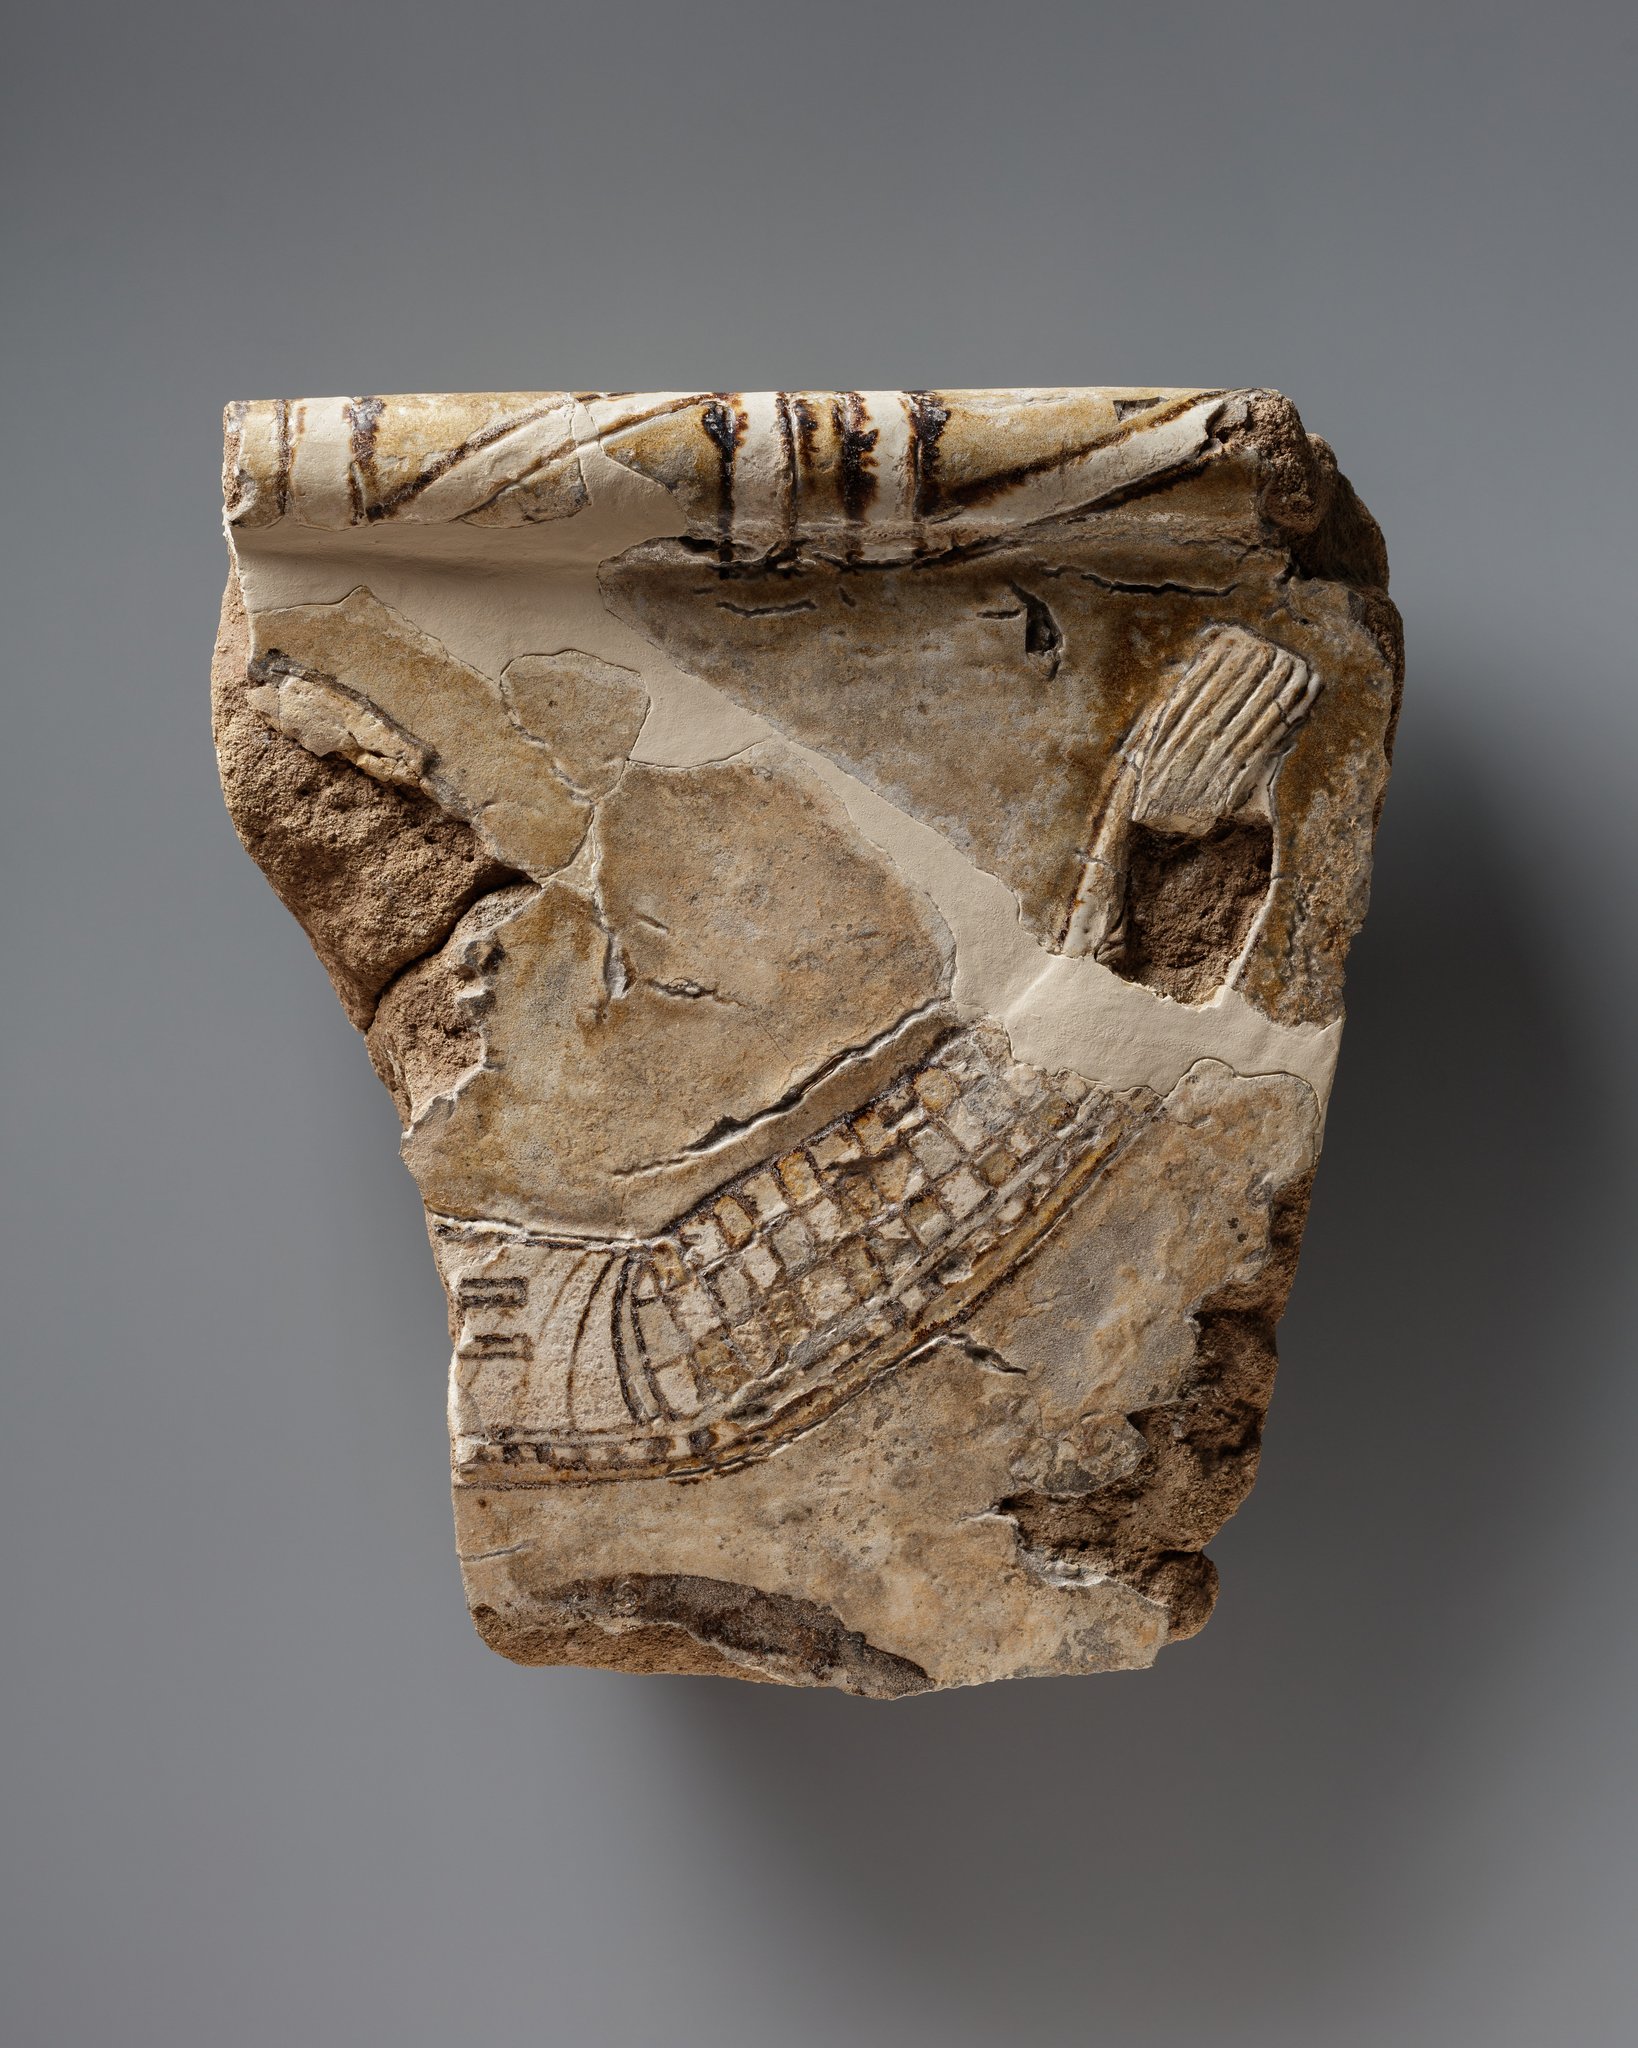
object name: tile inlay, palace of ramesses ii, foreigner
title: Tile from Side of Stairway to Dais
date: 1279-1213 BCE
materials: faience, paste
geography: egypt